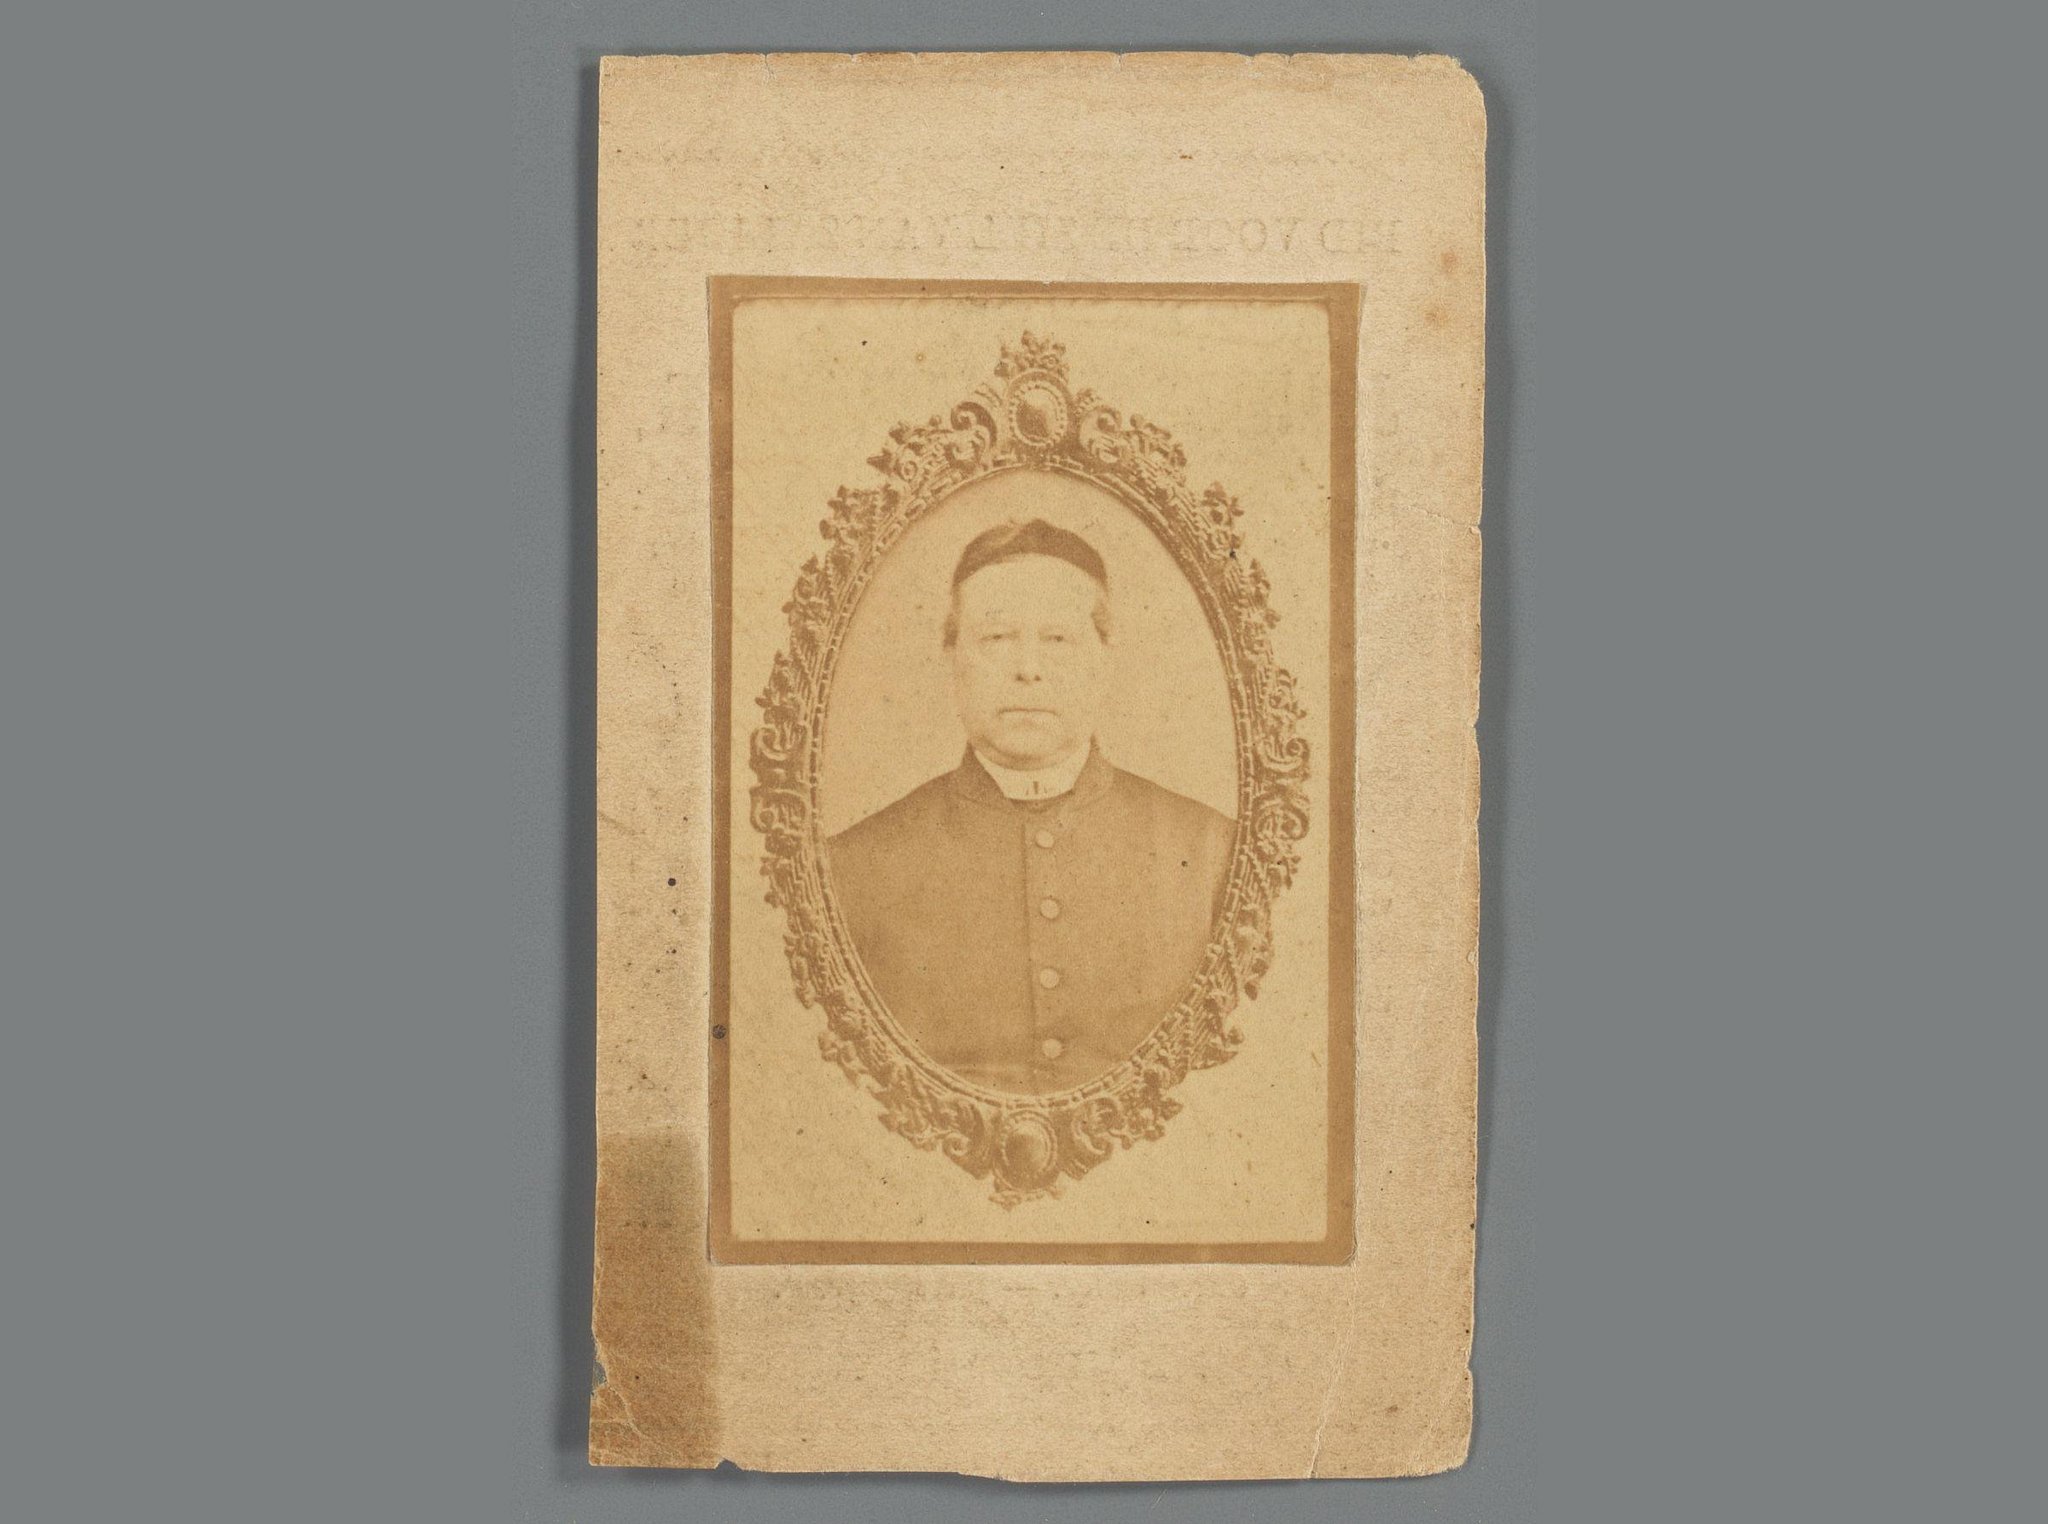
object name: photograph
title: Portret van Joannes Henricus Bauer op bidprent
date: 1867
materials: paper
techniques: albumen print, letterpress printing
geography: leeuwarden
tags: priest (roman catholic), historical persons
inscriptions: inscription: ‘Bid voor de ziel van zaliger (...) Dat hij ruste in vrede./ G.A. de Groot, Vleeschmarkt, Leeuwarden.’